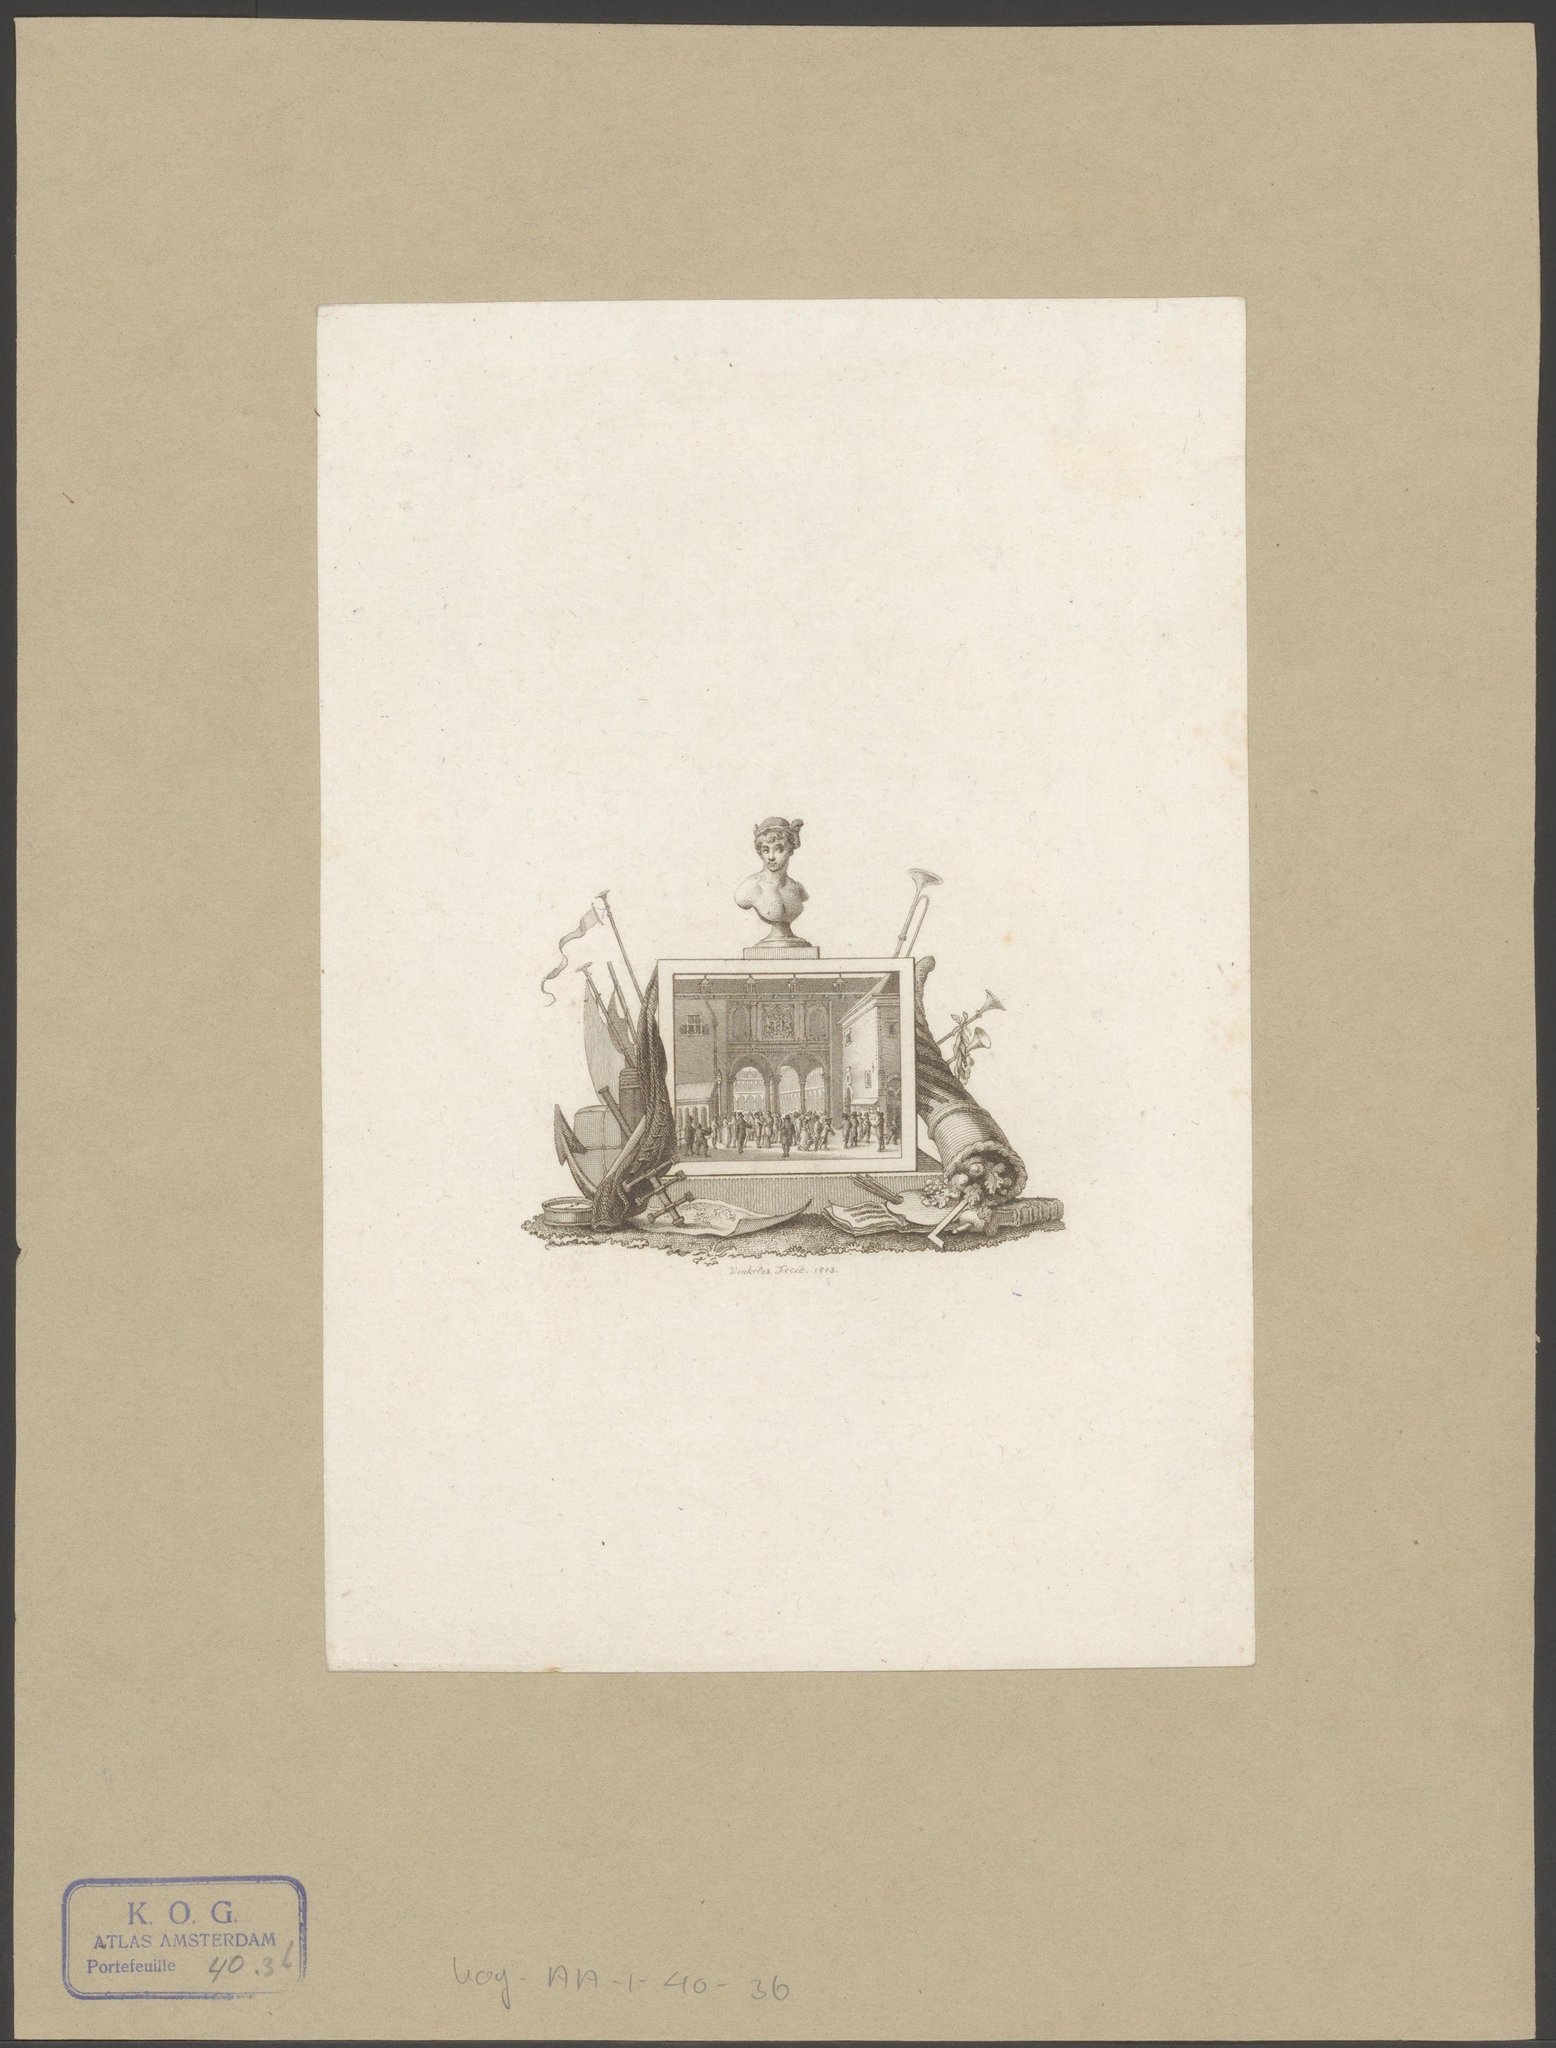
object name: print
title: Gezicht op de voorzijde van de Beurs van Hendrik de Keyser te Amsterdam in een allegorische omlijsting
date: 1813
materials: paper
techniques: etching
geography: amsterdam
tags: 'cornucopia', horn of plenty, (story of) mercury (hermes), stock exchange, stock-market, gate, entrance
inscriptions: collector's mark: Lugt 1641b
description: Prent mogelijk uit: Loots, Cornelis. Dichtstuk ter gelegenheid van het tweede eeuwgetijde der Beurs van Amsterdam. Amsterdam: Jacobus Ruys, 1813.